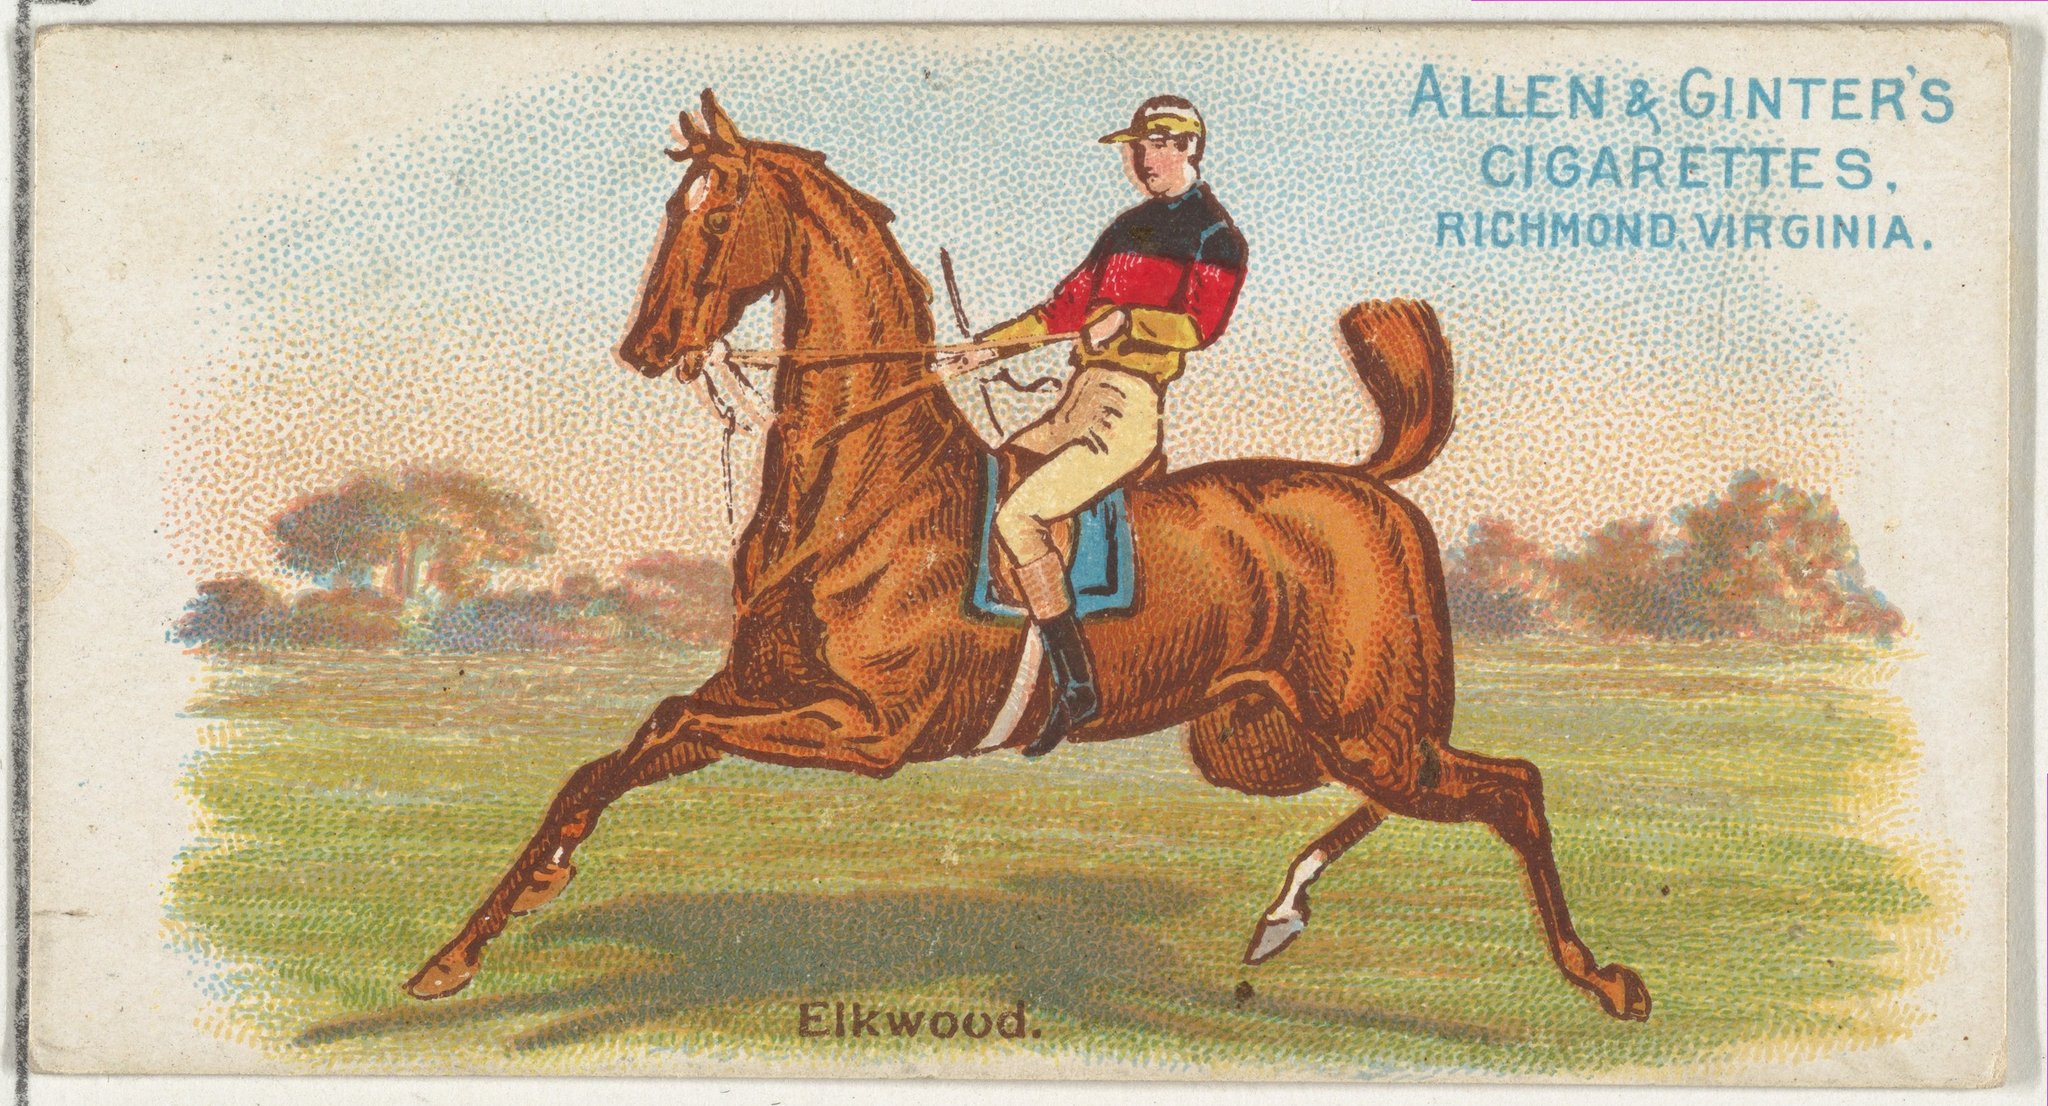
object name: print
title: Elkwood, from The World's Racers series (N32) for Allen & Ginter Cigarettes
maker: allen & ginter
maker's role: publisher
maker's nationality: american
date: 1888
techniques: color lithograph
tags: men,horses,jockeys